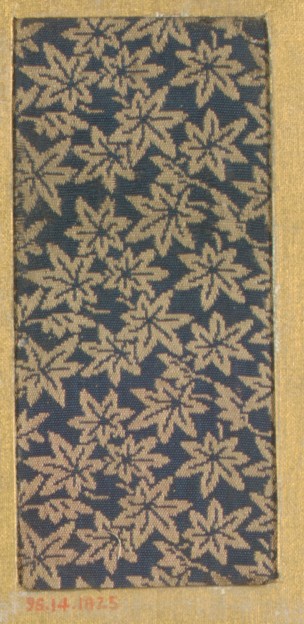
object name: piece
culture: japanese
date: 1701-1900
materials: silk